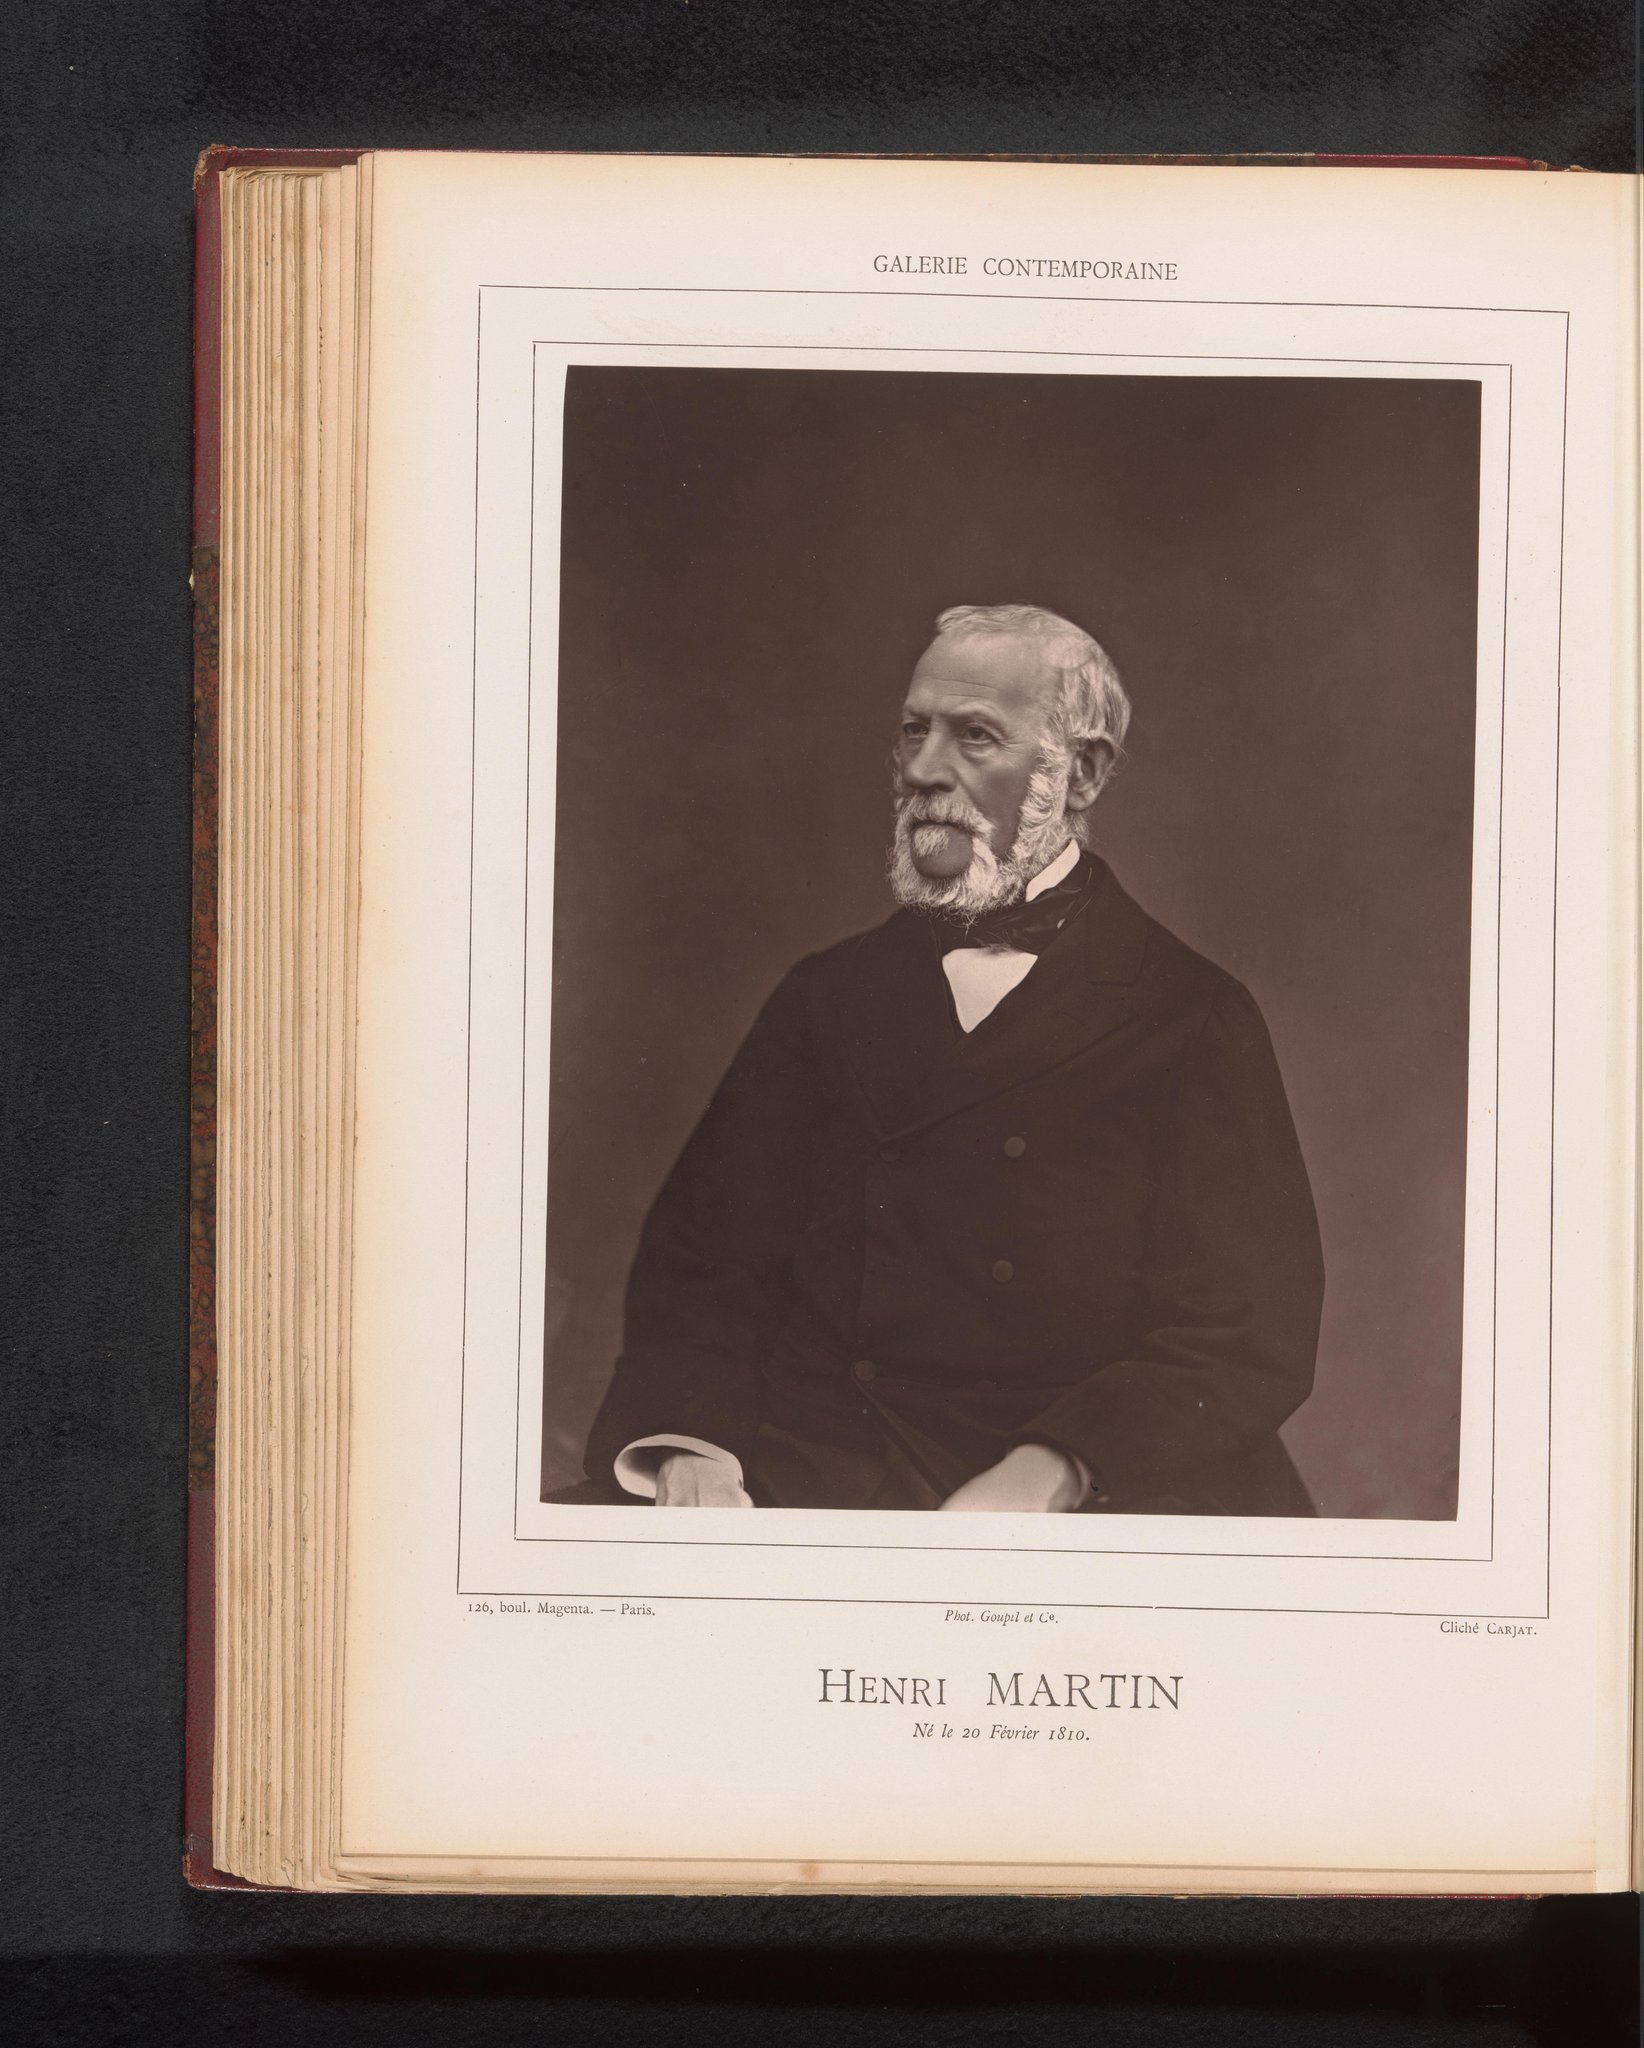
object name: photomechanical print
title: Portret van Henri Martin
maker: étienne carjat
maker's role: draughtsman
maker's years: 1828-1906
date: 1872-1877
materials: paper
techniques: woodburytype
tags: politician, adult man, historical persons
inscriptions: inscription: ‘Galerie Contemporaine/ 126, boul. Magenta. - Paris/ Né le 20 Février 1810.’